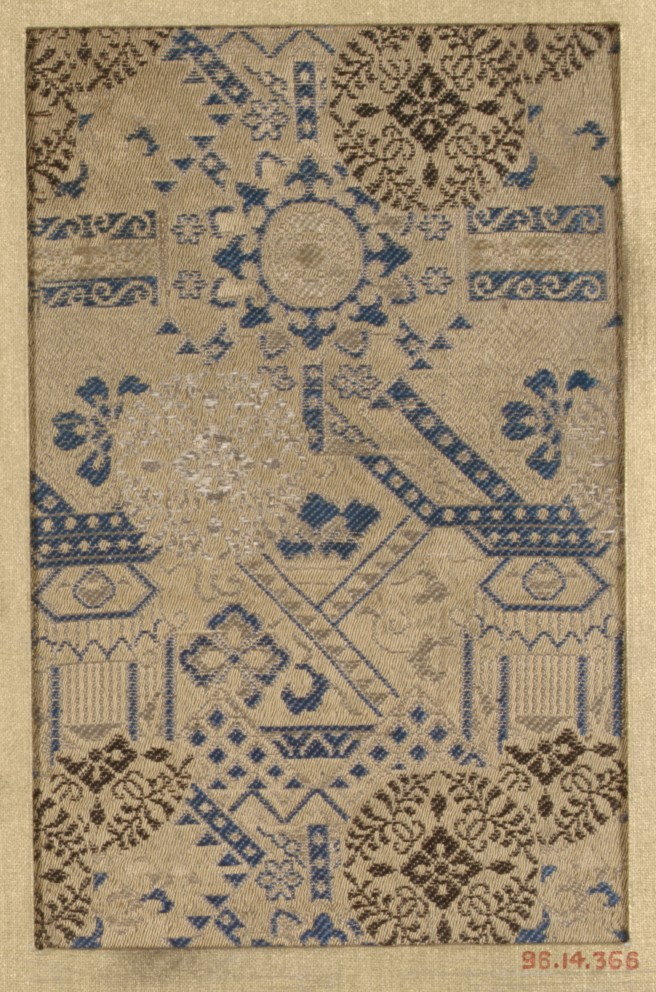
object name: piece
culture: japanese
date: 1701-1900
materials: silk